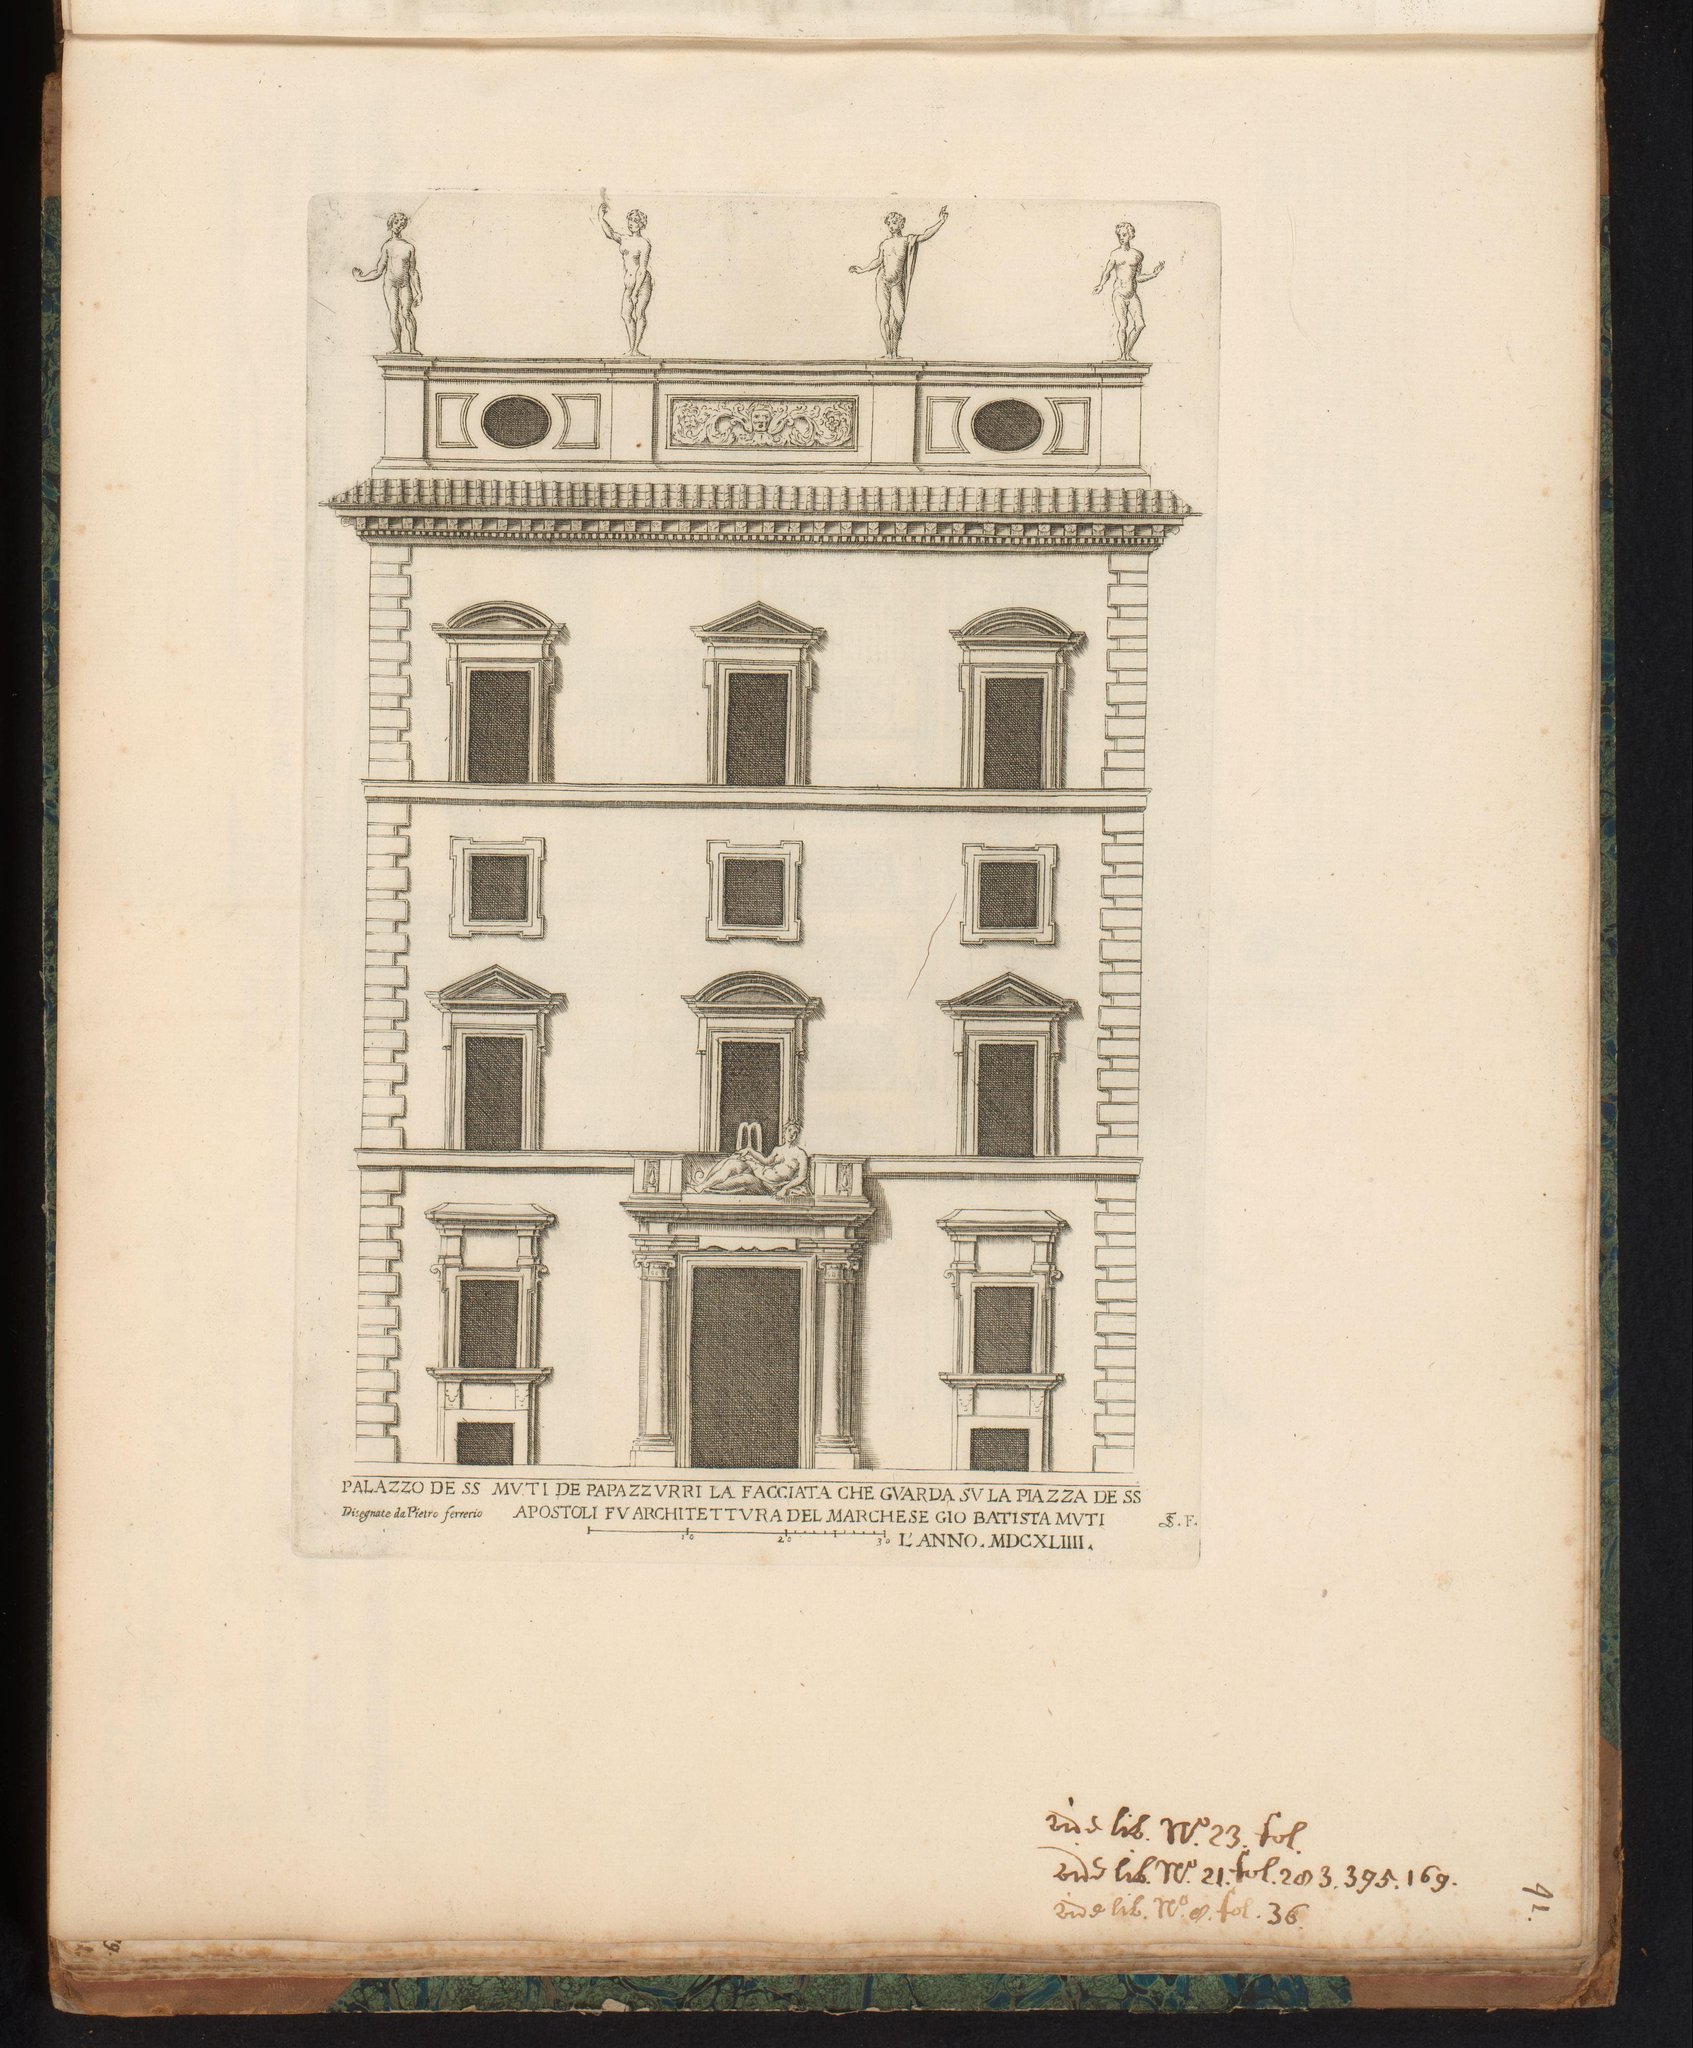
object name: album leaf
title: Palazzi di Roma dei più celebri architett (...)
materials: paper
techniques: etching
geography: italy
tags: palace, façade (of house or building)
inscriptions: inscription: ‘Ende lib. No. 23 fol./ Ende lib. No. 21. fol. 283. 395. 169./ Ende lib. No. 8. fol. 36.’, number: ‘41’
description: Deze prent maakt deel uit van de reeks getiteld: Palazzi di Roma. Deze reeks bestaat uit twee boeken. Boek één getiteld: Palazzi di Roma dei più celebri architetti..., bestaat uit 44 prenten die worden toegeschreven aan Giovanni Battista Falda (naam staat enkel op prent 27) en uitgegeven door Giovanni Giacomo de'Rossi. Deze 44 prenten zijn bekend in twee staten (met en zonder nummer). Boek twee getiteld: Nuovi disegni dell'architetture... libro secondo, bevat 66 prenten door Giovanni Battista Falda en Simone Felice. Deze 66 prenten zijn bekend in twee staten (met en zonder nummer).